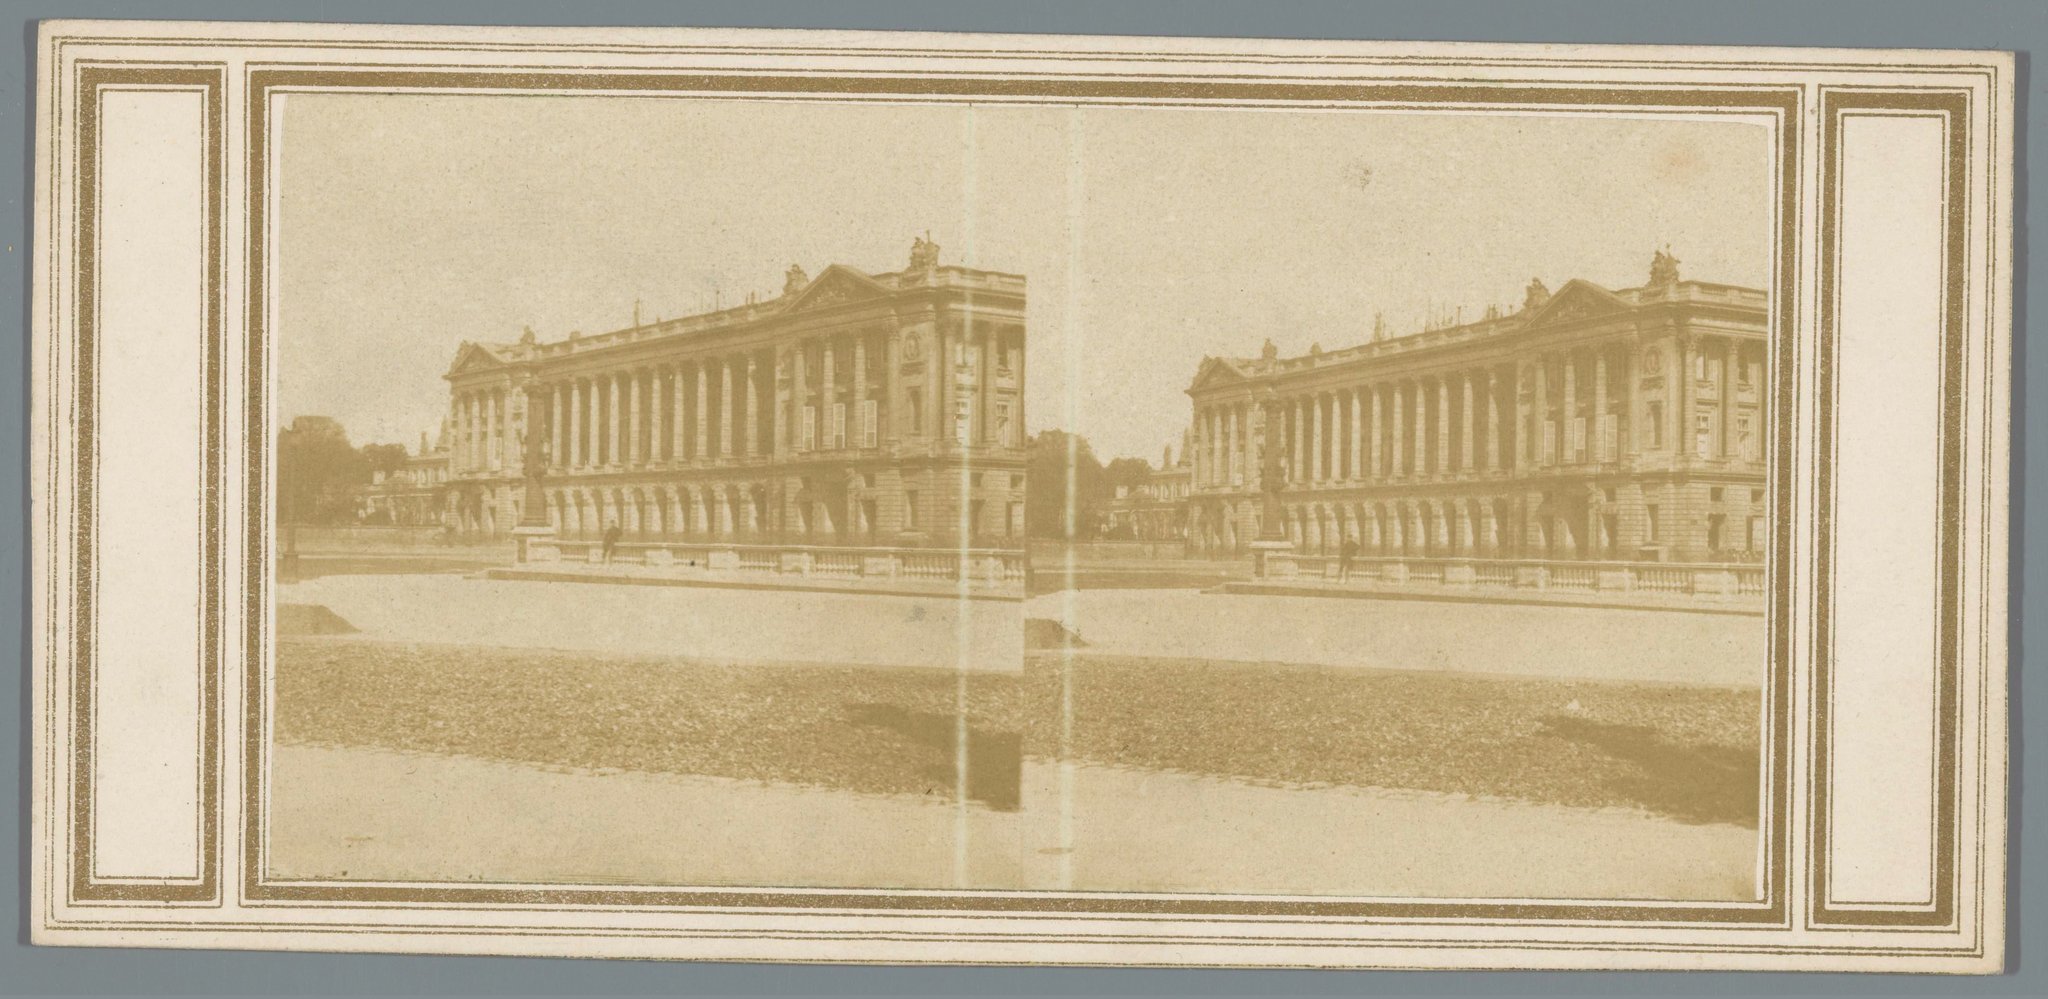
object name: stereograph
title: Gezicht op het Hôtel du Garde-Meuble aan het Place de la Concorde in Parijs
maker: Anonymous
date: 1855-1860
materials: cardboard, photographic support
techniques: albumen print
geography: paris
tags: façade (of house or building)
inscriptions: inscription: ‘Garde-Meuble sur la place de la Concorde - Paris -’